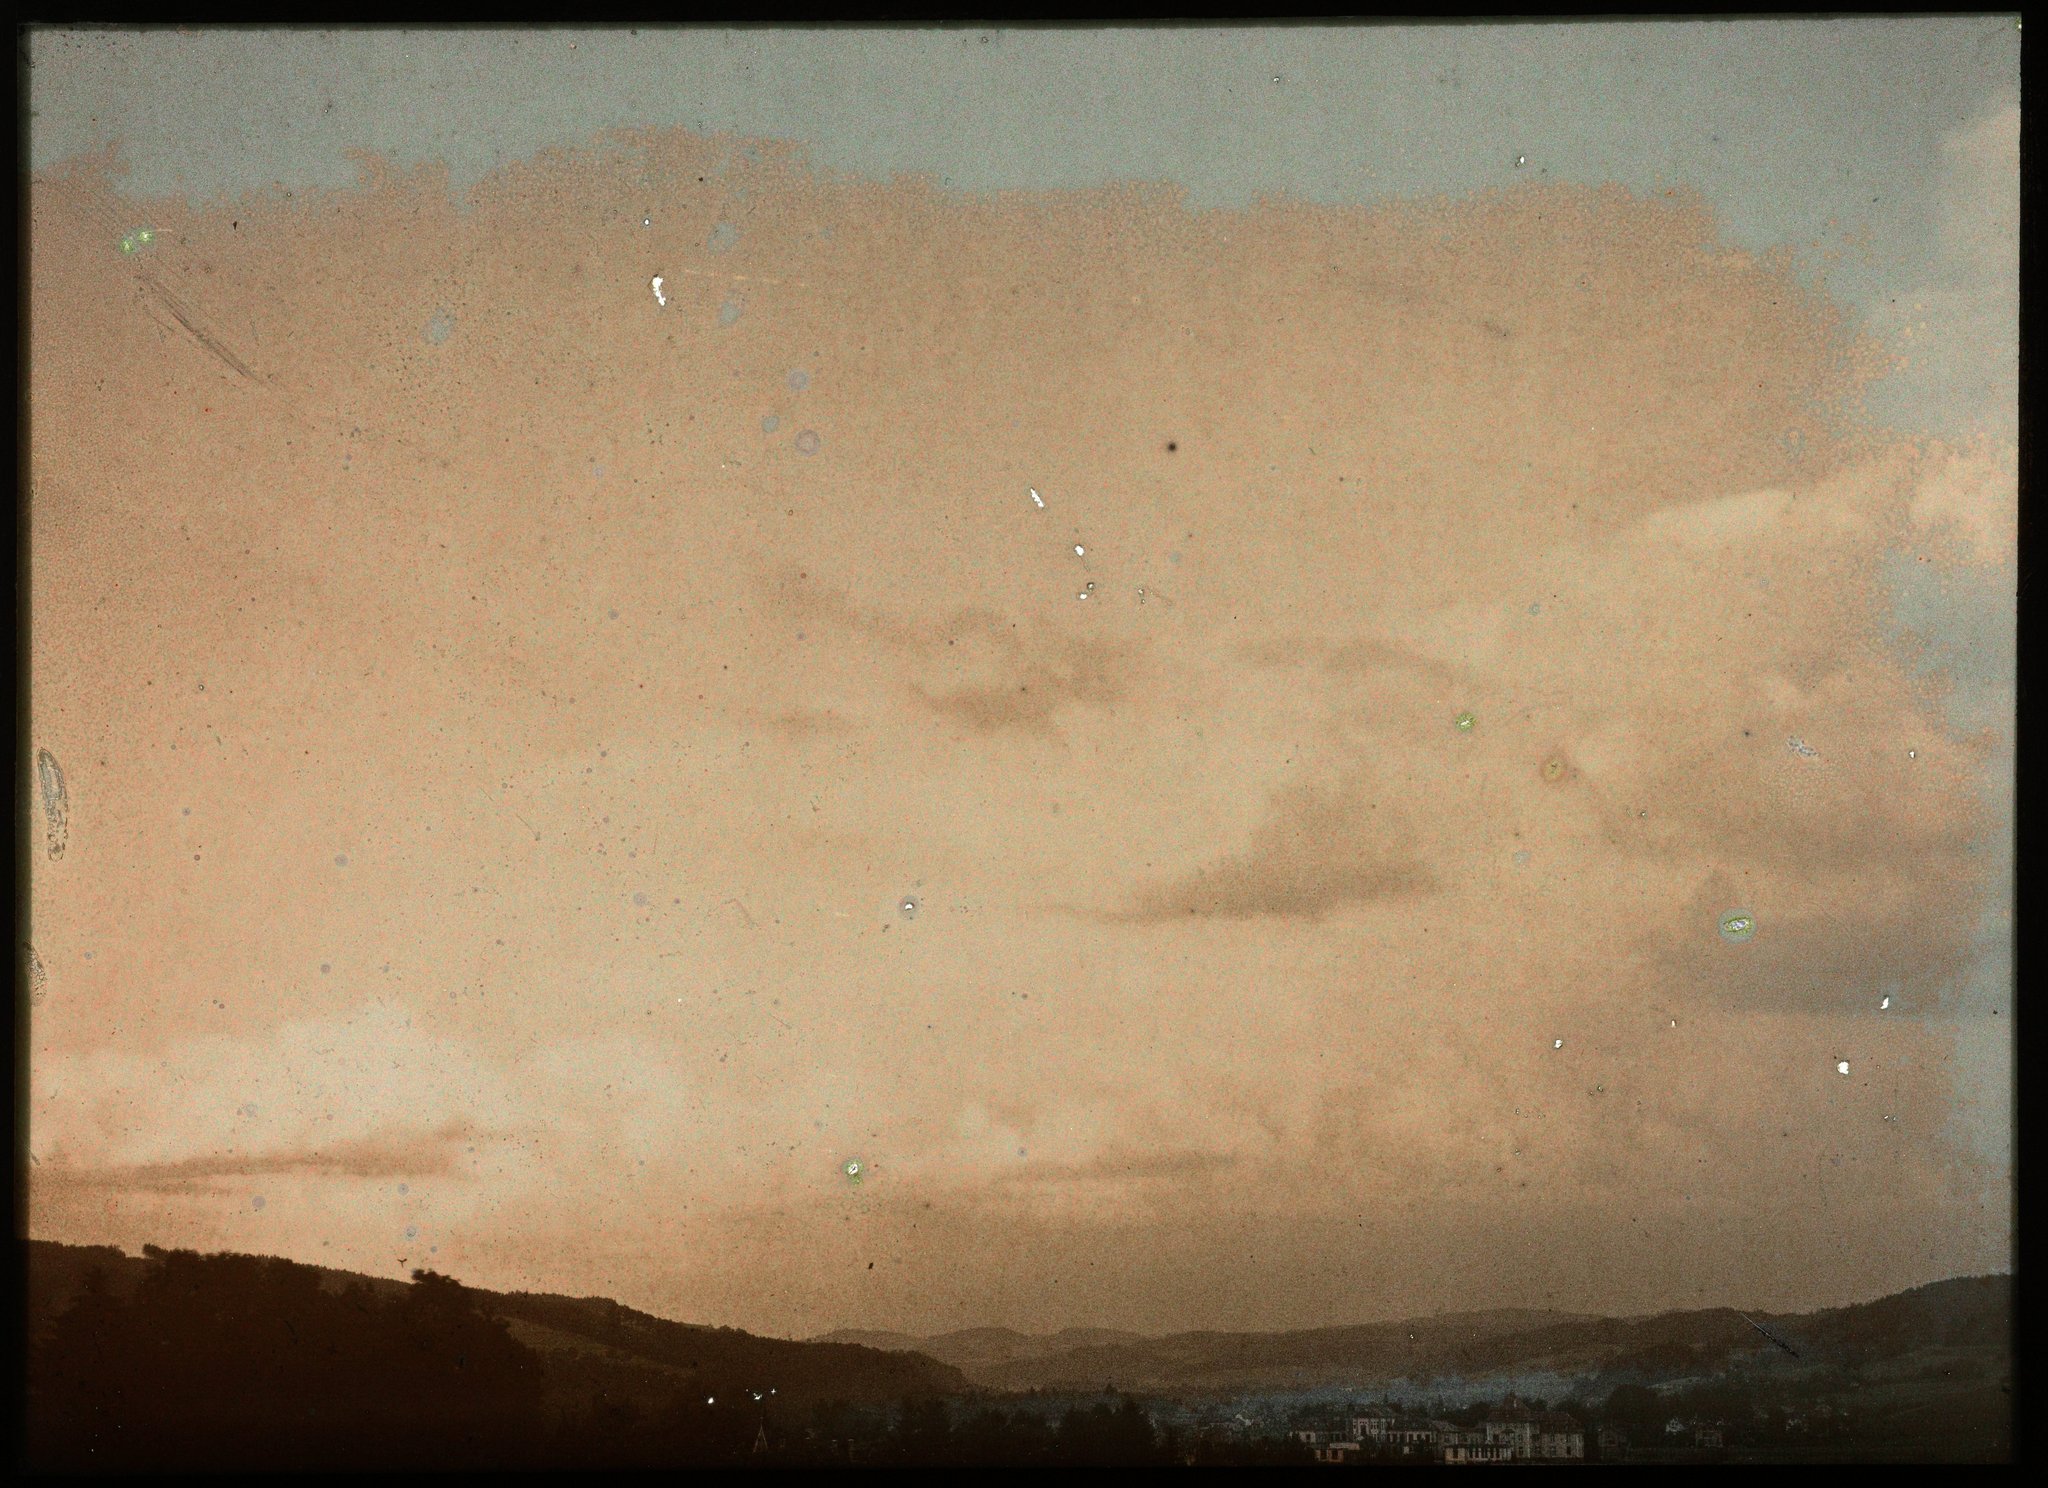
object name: color slide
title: Zonsondergang boven een dal, met een stadje met witte huizen middenvoor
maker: adolphe burdet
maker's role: fotograaf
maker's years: 1860-1940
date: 1907-1930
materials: glass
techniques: autochrome process, slide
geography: switzerland